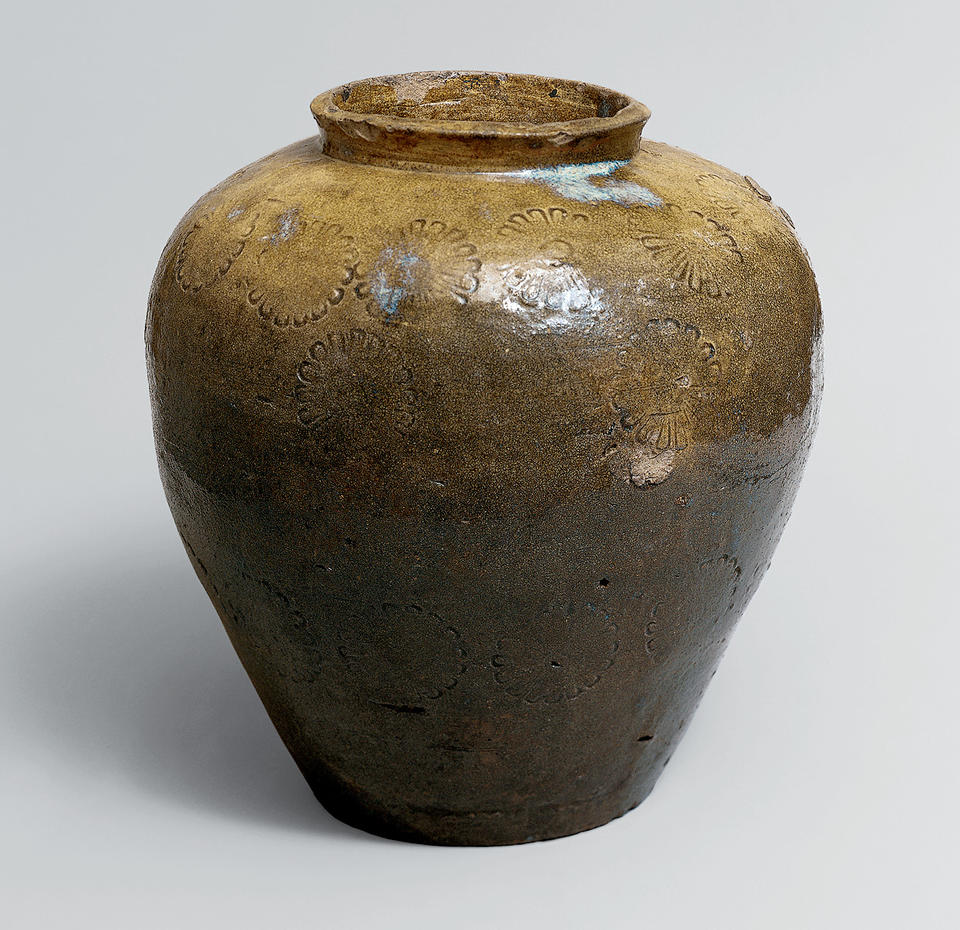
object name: jar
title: Jar (Tsubo) with Chrysanthemums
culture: japanese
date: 1267-1333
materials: wood, stoneware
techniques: glazing, stamping